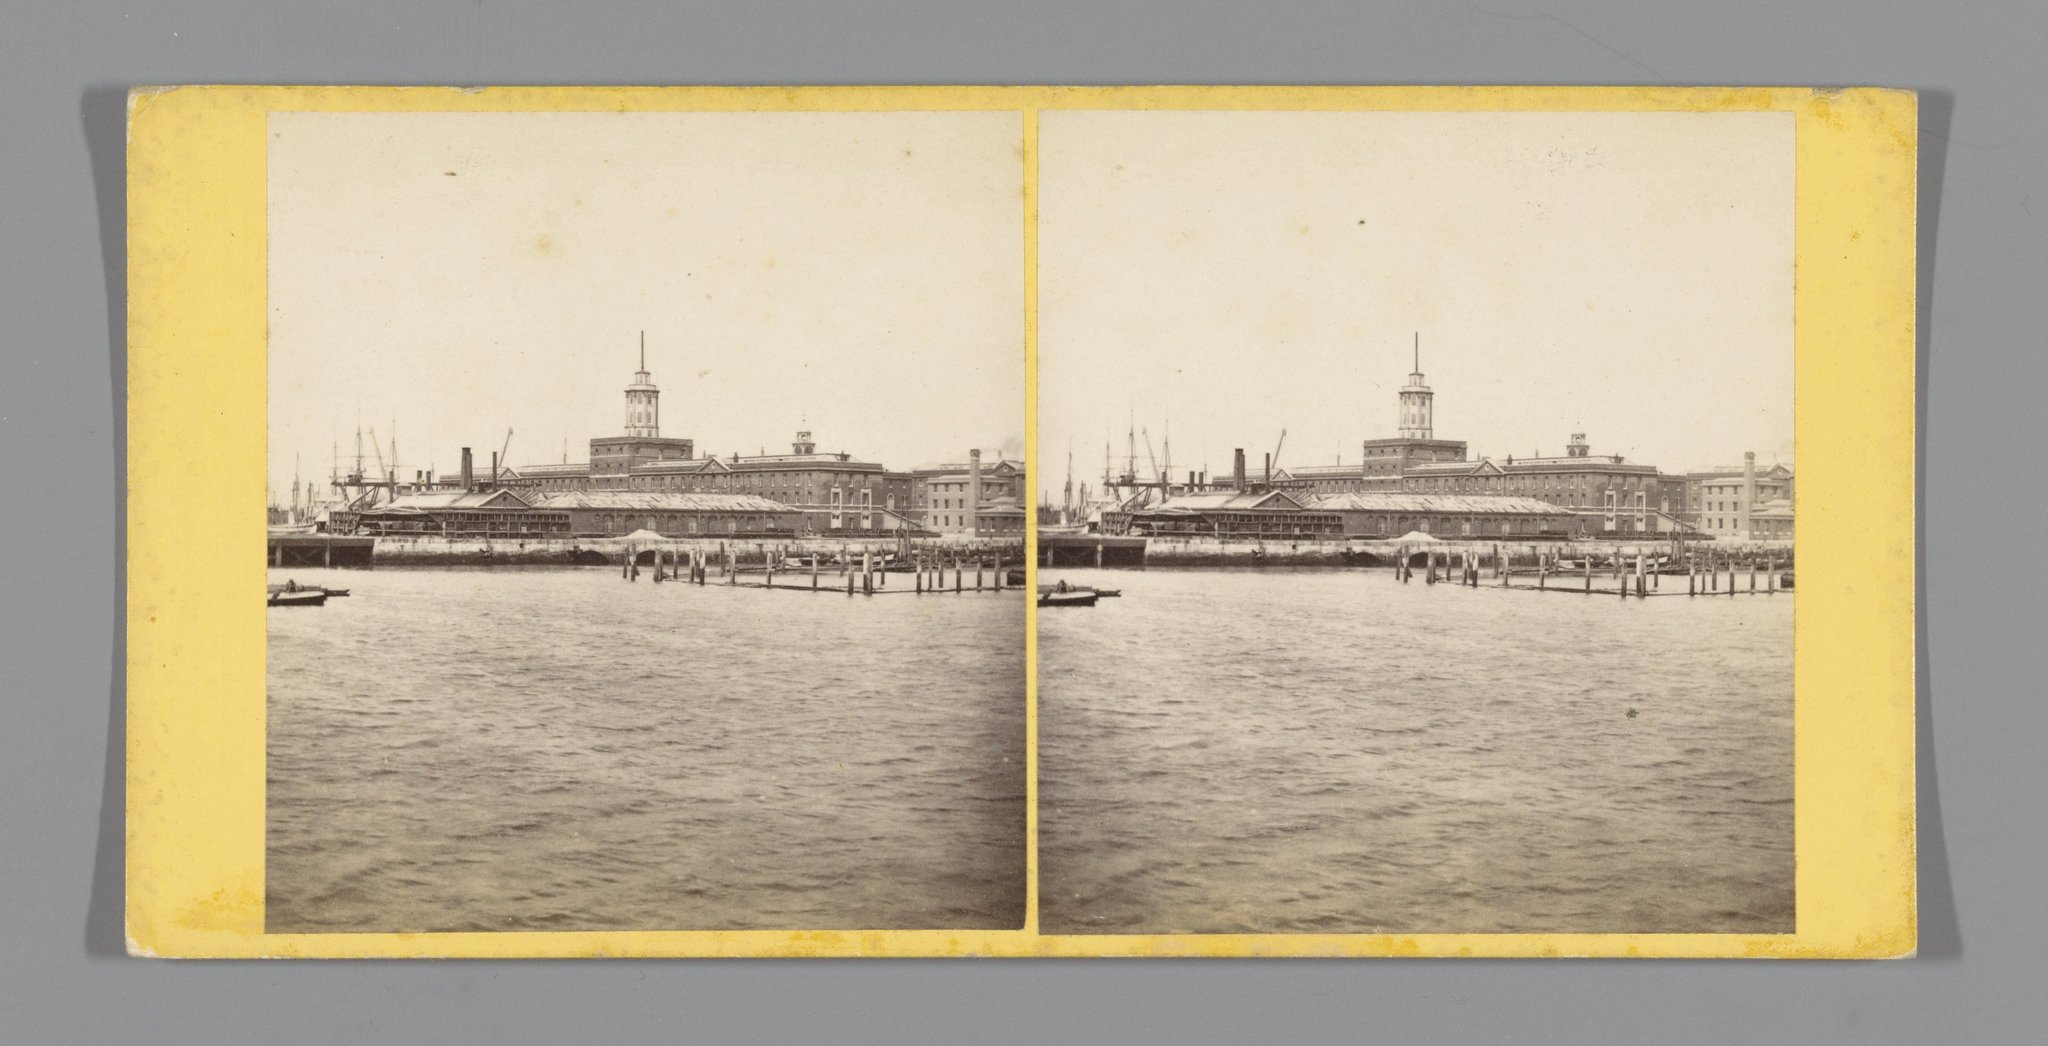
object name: stereograph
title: Gezicht op de scheepswerf van Portsmouth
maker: george washington wilson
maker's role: publisher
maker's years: 1823-1893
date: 1850-1880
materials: cardboard, photographic support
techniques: albumen print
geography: portsmouth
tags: harbour, portsmouth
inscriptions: number: ‘No. 423.’, name: ‘G. W. Wilson, Photographer, Aberdeen.’